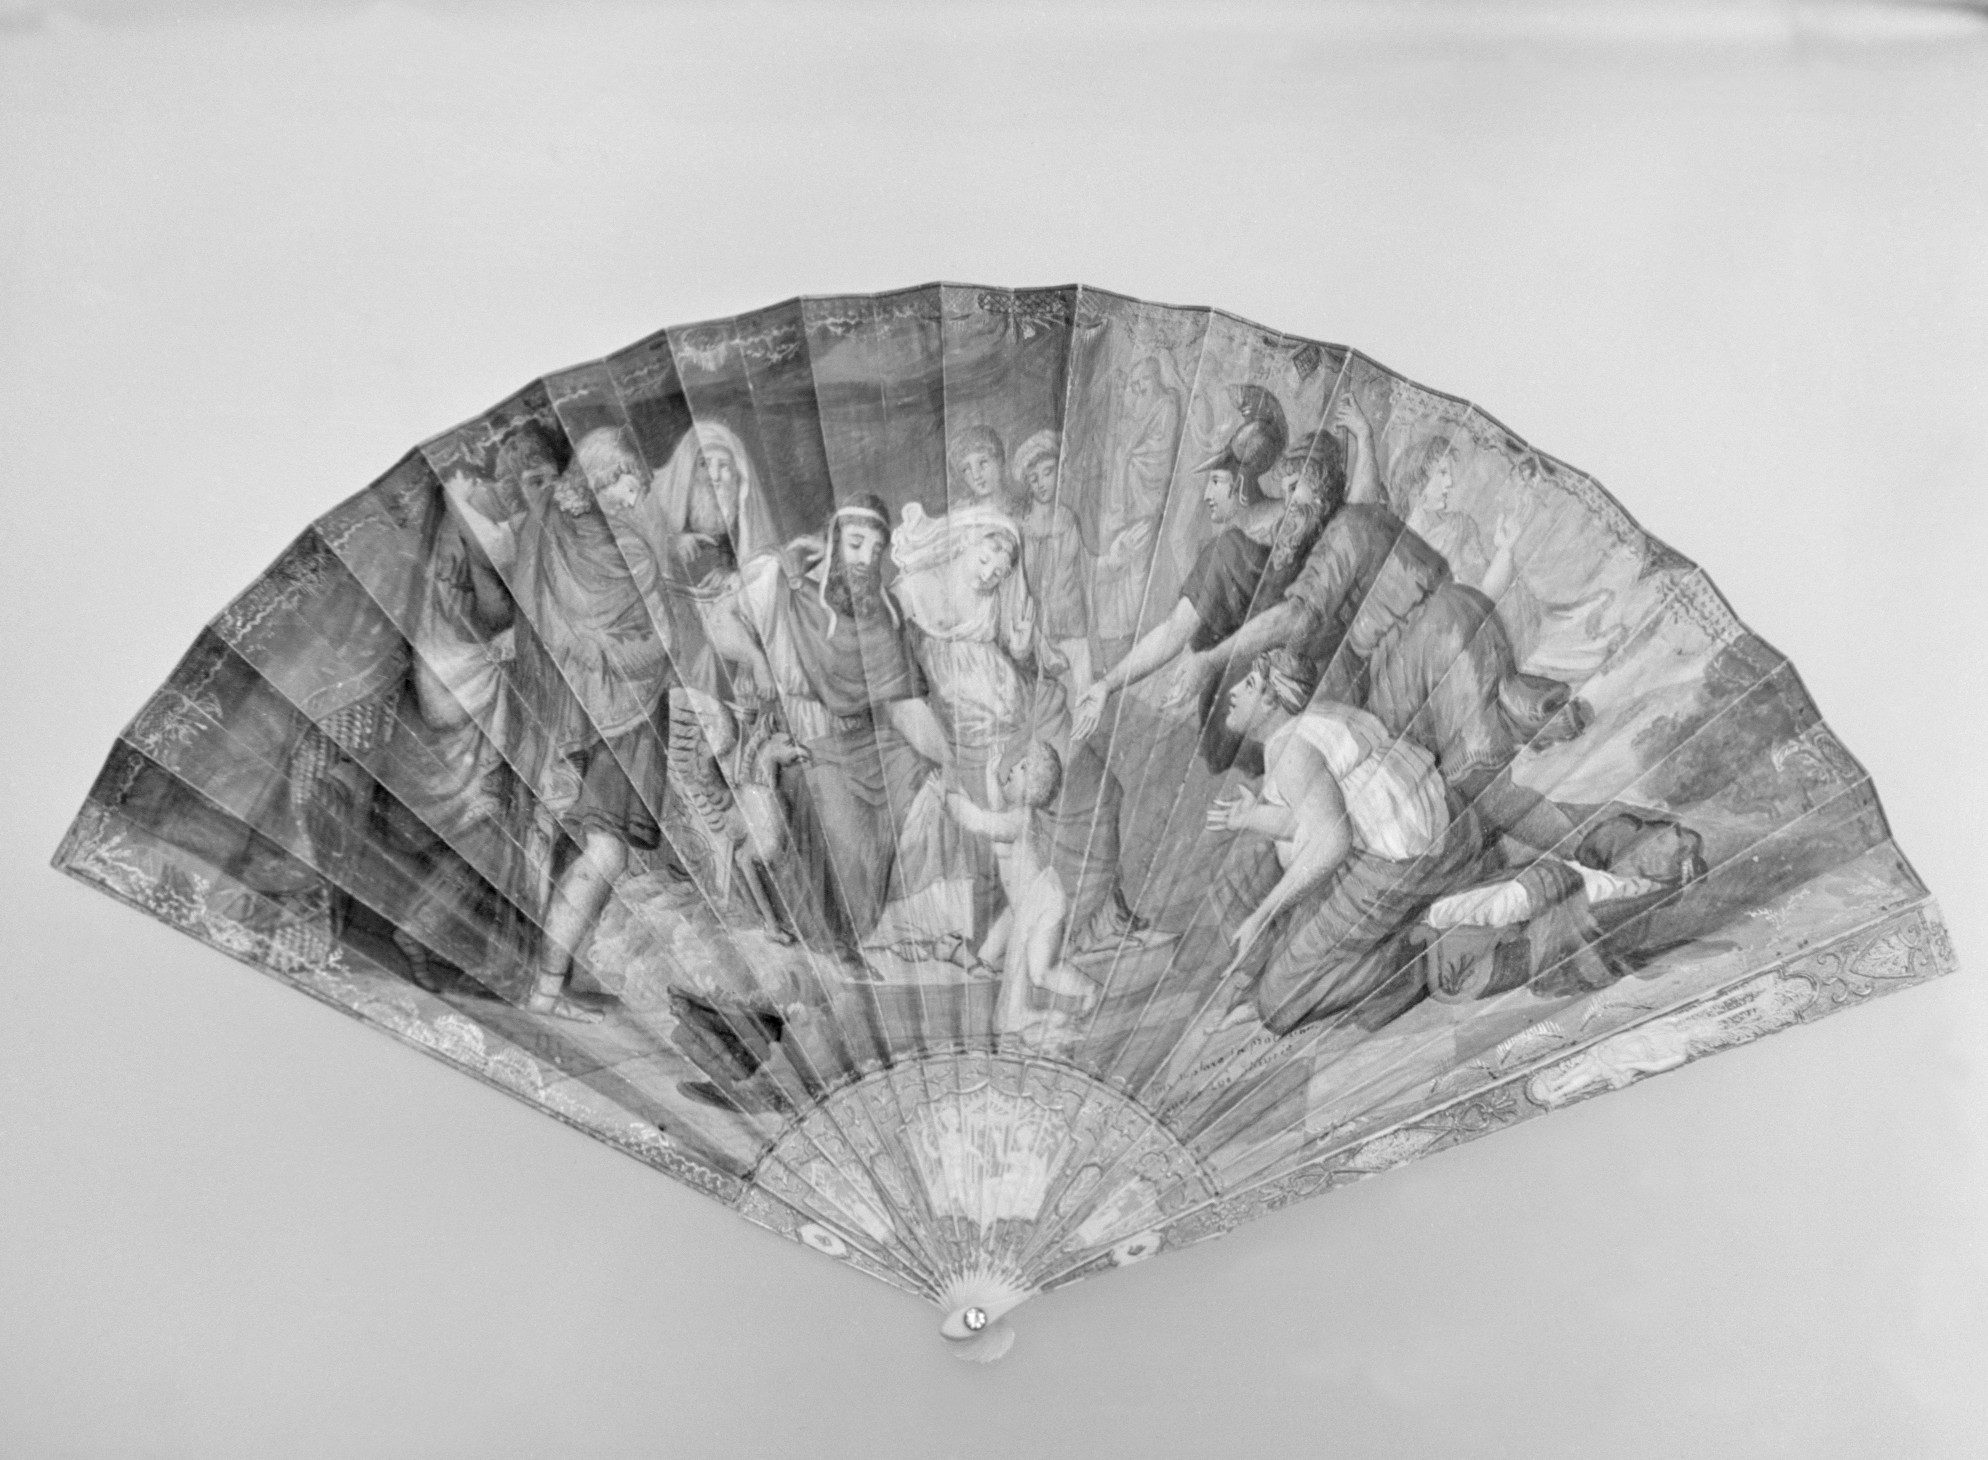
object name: fan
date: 1815-1840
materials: glass, gold, ivory, paper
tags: children,men,women